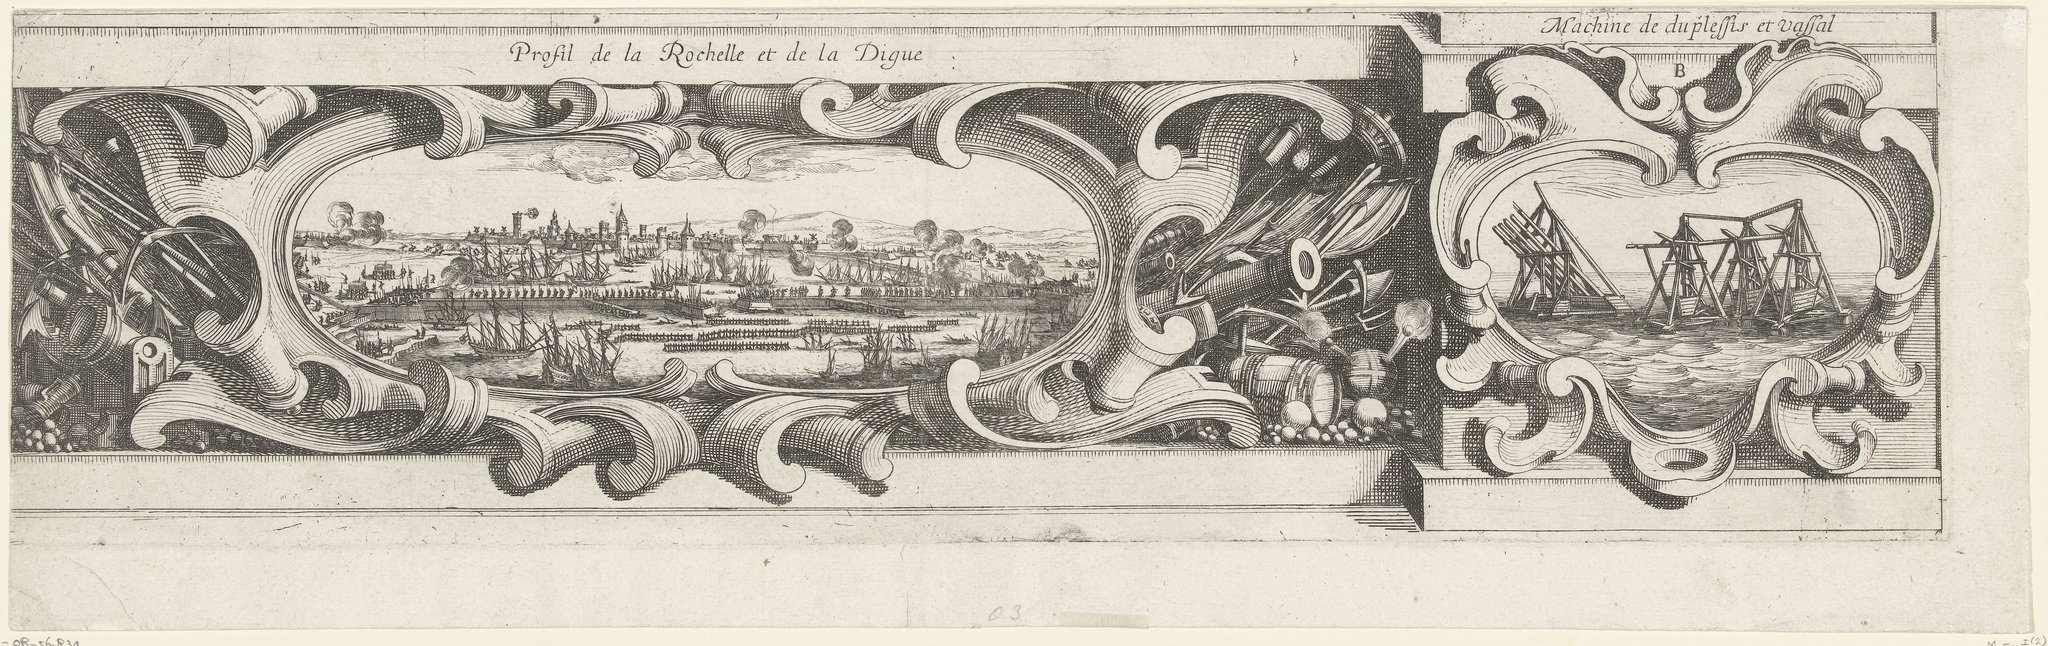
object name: print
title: Profil de la Rochelle et de la Digue / Machine de du plessis et vassal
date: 1628-1631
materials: paper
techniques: engraving, etching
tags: ornament ~ cartouche, fortified city, temporary fortifications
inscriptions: collector's mark: Lugt 240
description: Zestiende deel (randwerk, deel rechtsonder) van een prent van het beleg van het hugenotenbolwerk La Rochelle in de jaren 1627 en 1628, dat werd uitgevoerd in opdracht van de Franse koning door het Franse leger onder aanvoering van kardinaal Richelieu. Op dit blad rechts een voorstelling van een houten bouwwerk in zee en midden/links een voorstelling (omgeven door militaire attributen) van de dijk die Richelieu voor de ingang van de haven had laten bouwen om de stad af te sluiten.